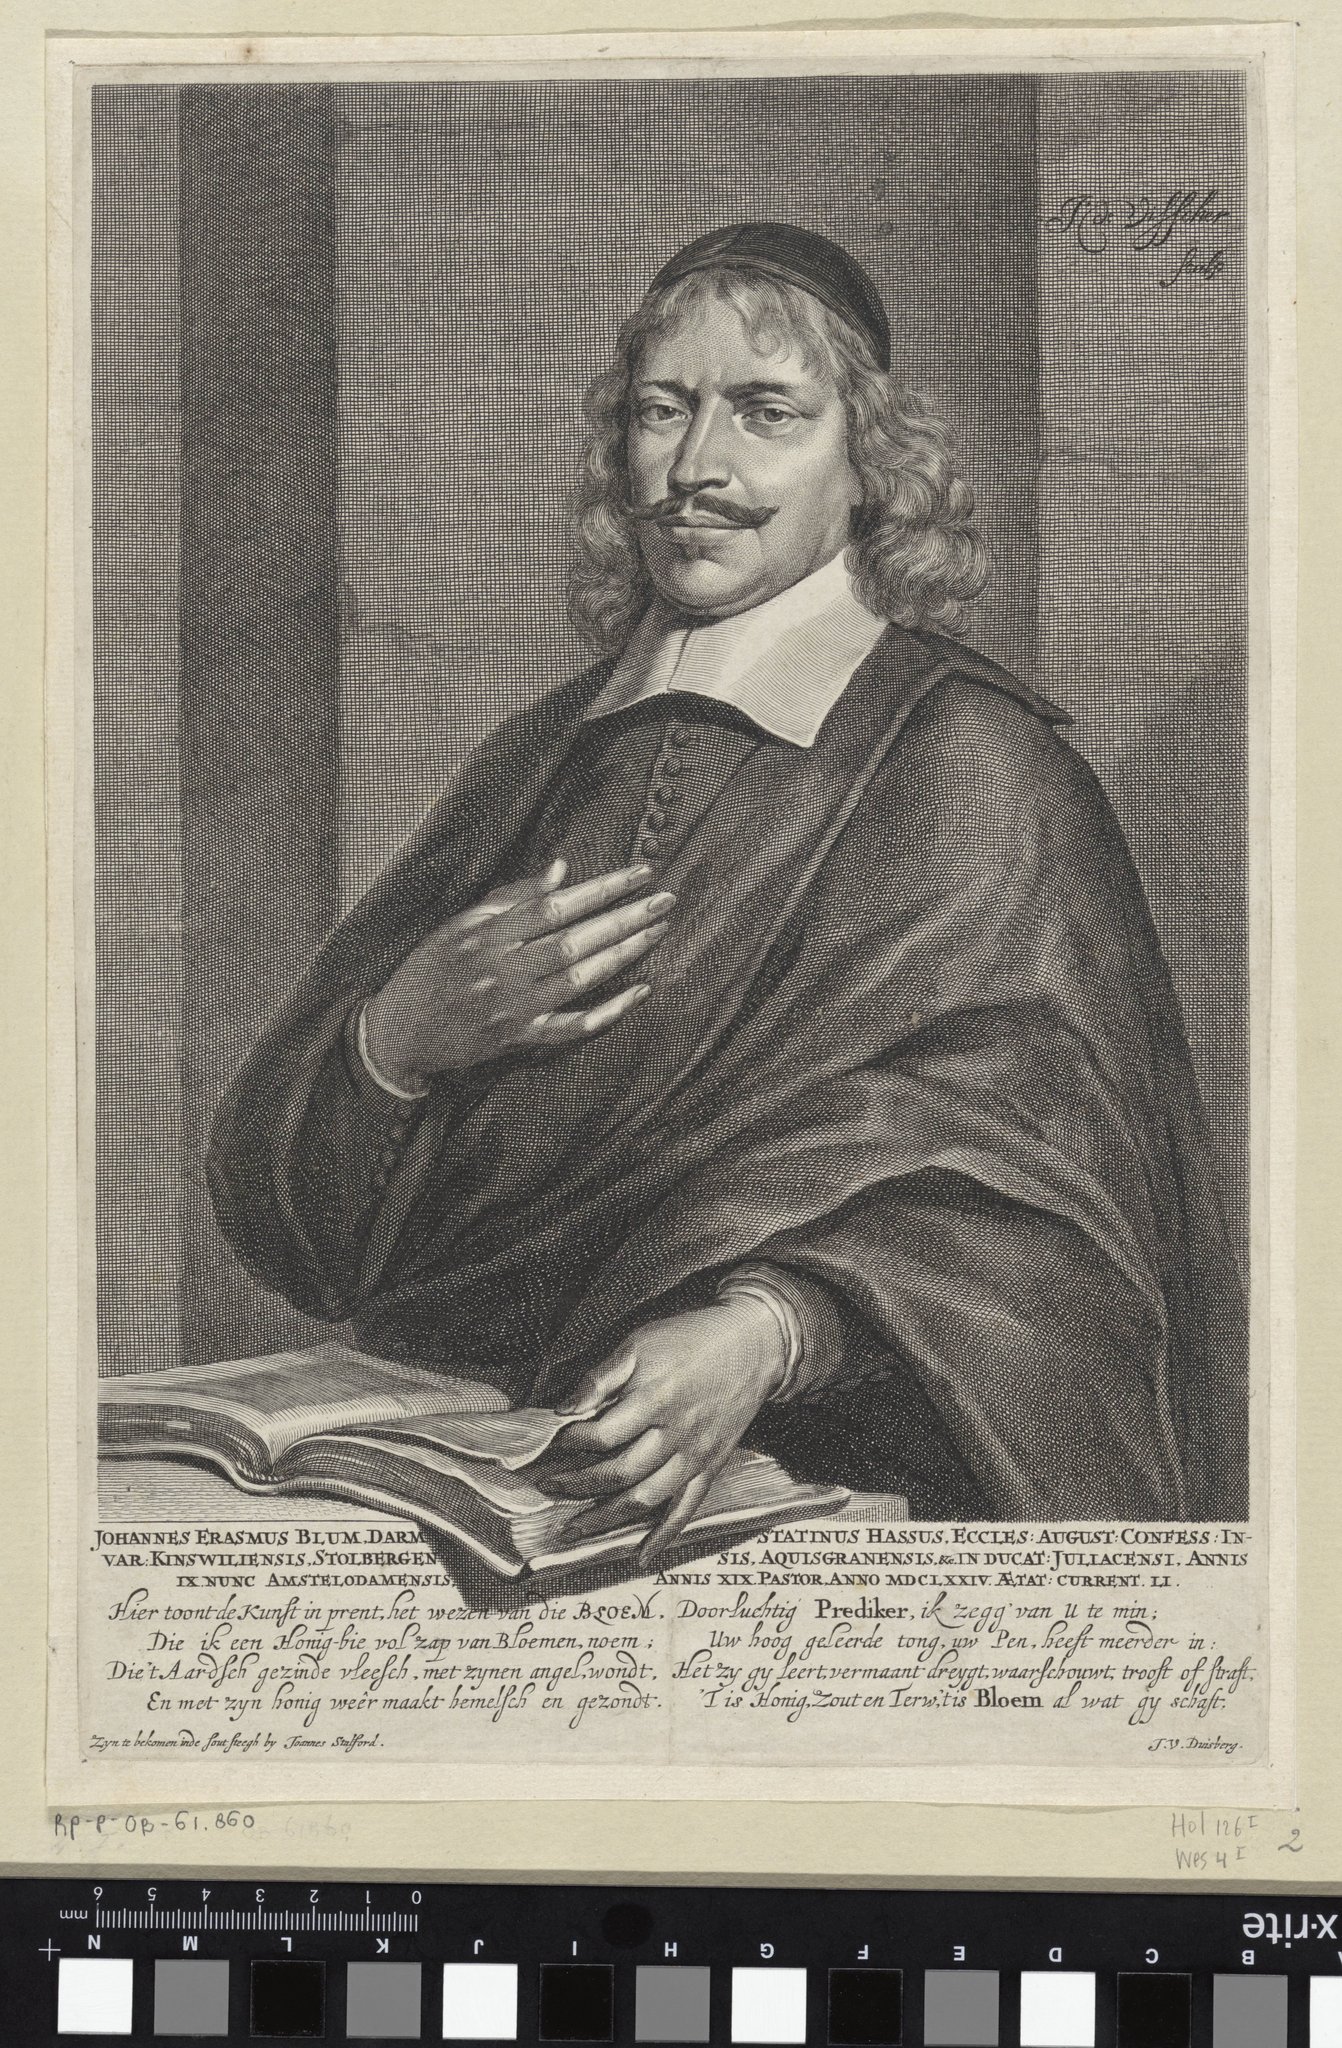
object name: print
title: Portret van Johannes Erasmus Blum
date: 1674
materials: paper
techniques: engraving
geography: amsterdam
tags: amsterdam, book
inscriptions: collector's mark: Lugt 240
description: De predikant Johannes Erasmus Blum houdt zijn rechterhand op de borst en bladert met zijn andere in het boek dat voor hem ligt. In de marge een lofdicht.